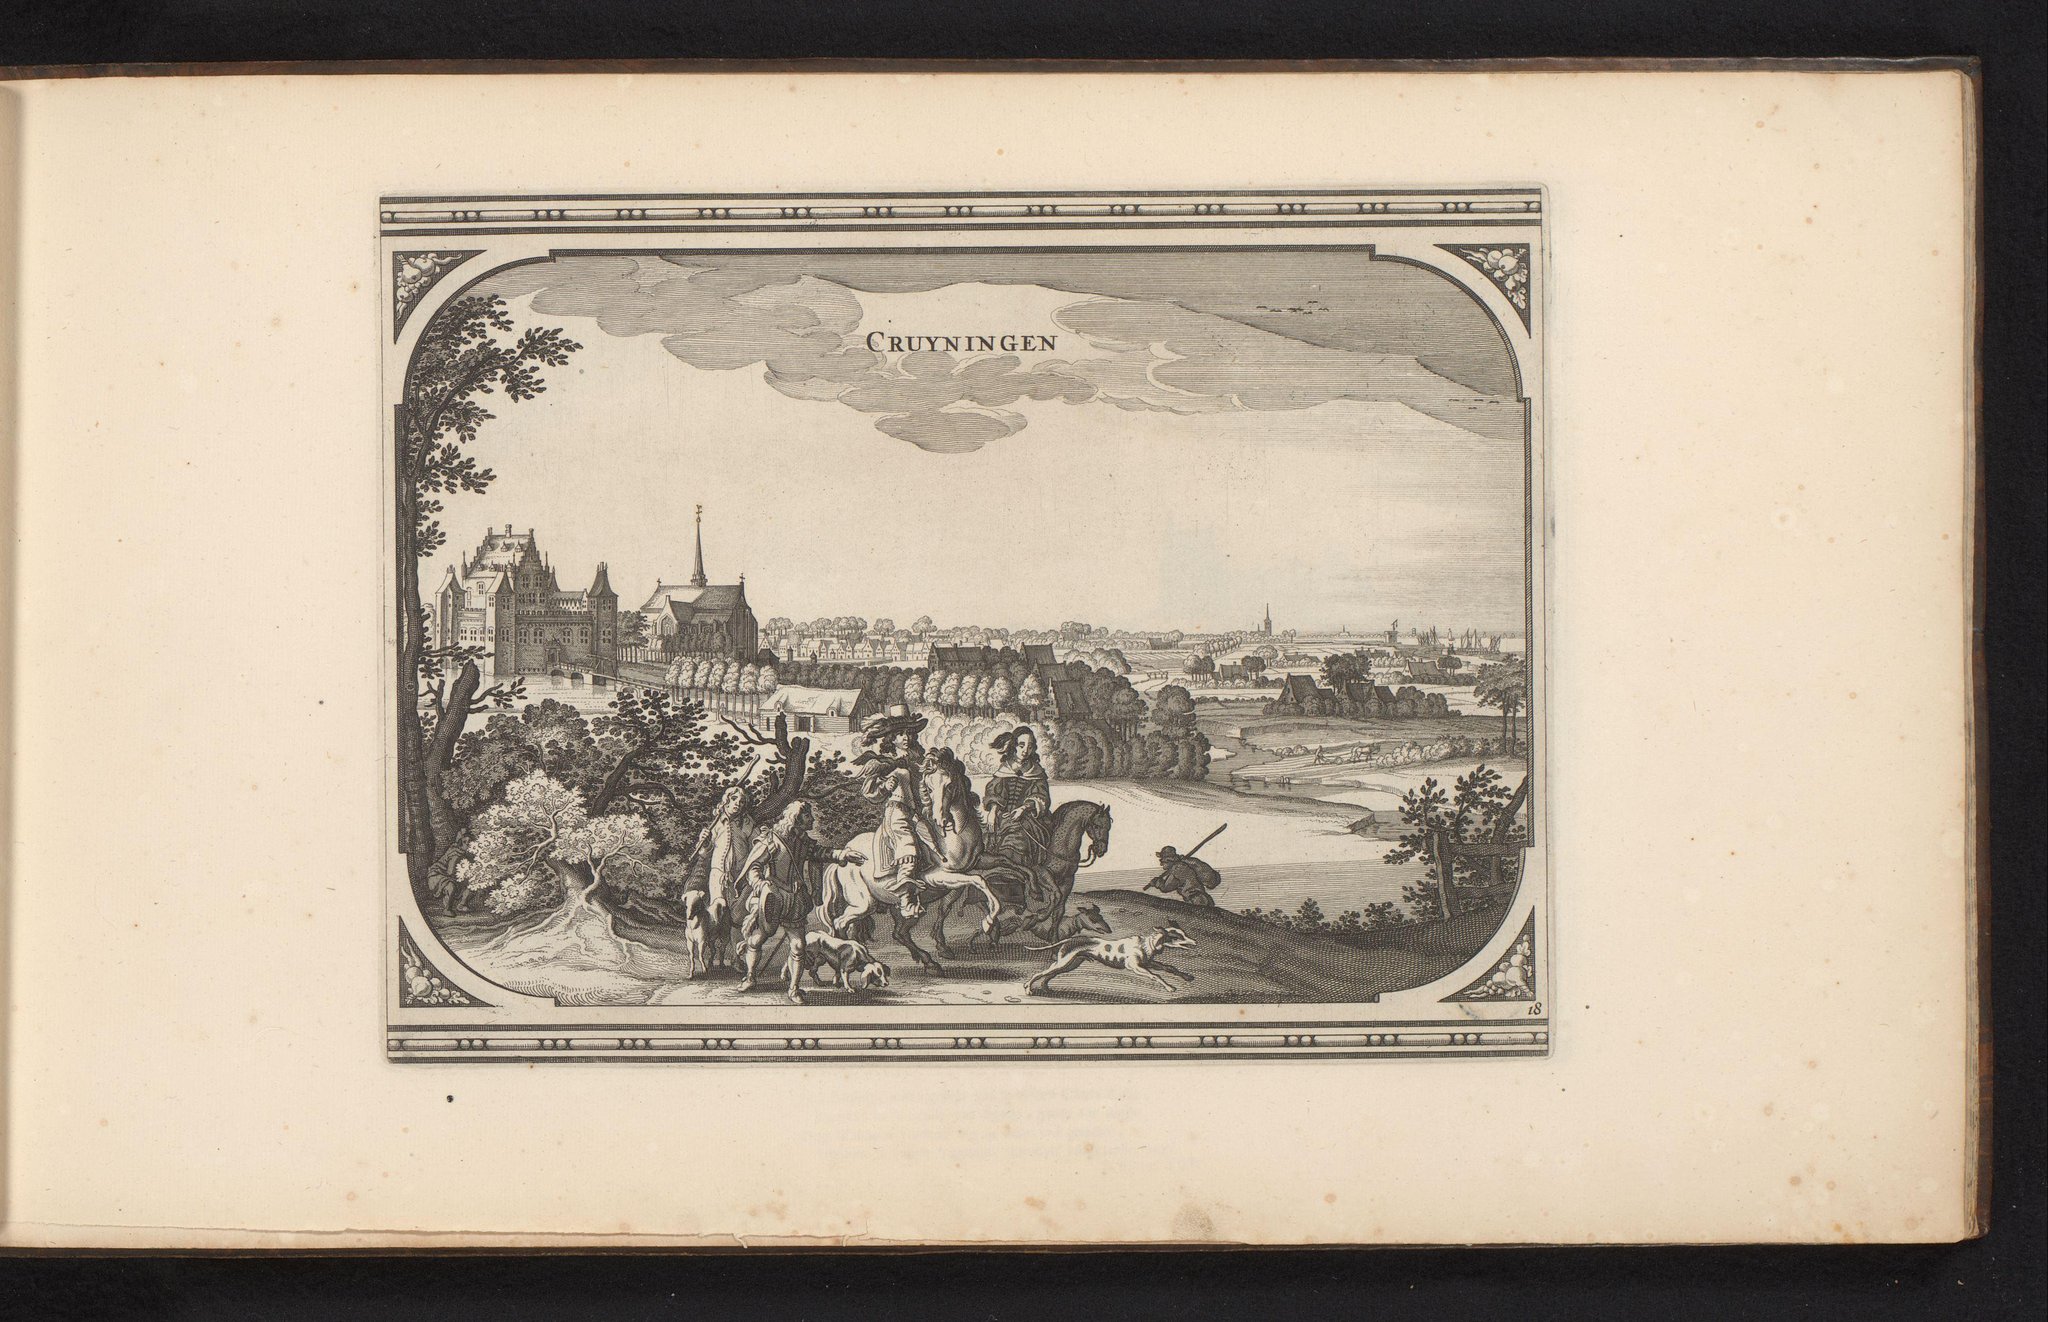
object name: print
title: Speculum Zelandiae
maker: pieter hendricksz. schut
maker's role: print maker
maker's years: 1618-1660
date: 1662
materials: paper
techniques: etching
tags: city-view, and landscape with man-made constructions, castle, hunting, chase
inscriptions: collector's mark: Lugt 195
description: Gezicht op Kruiningen in Zeeland. Op de voorgrond een welgesteld paar te paard. De man heeft twee jachthonden en een valk bij zich. Twee mannen wijzen het paar de weg. De prent maakt deel uit van een album.